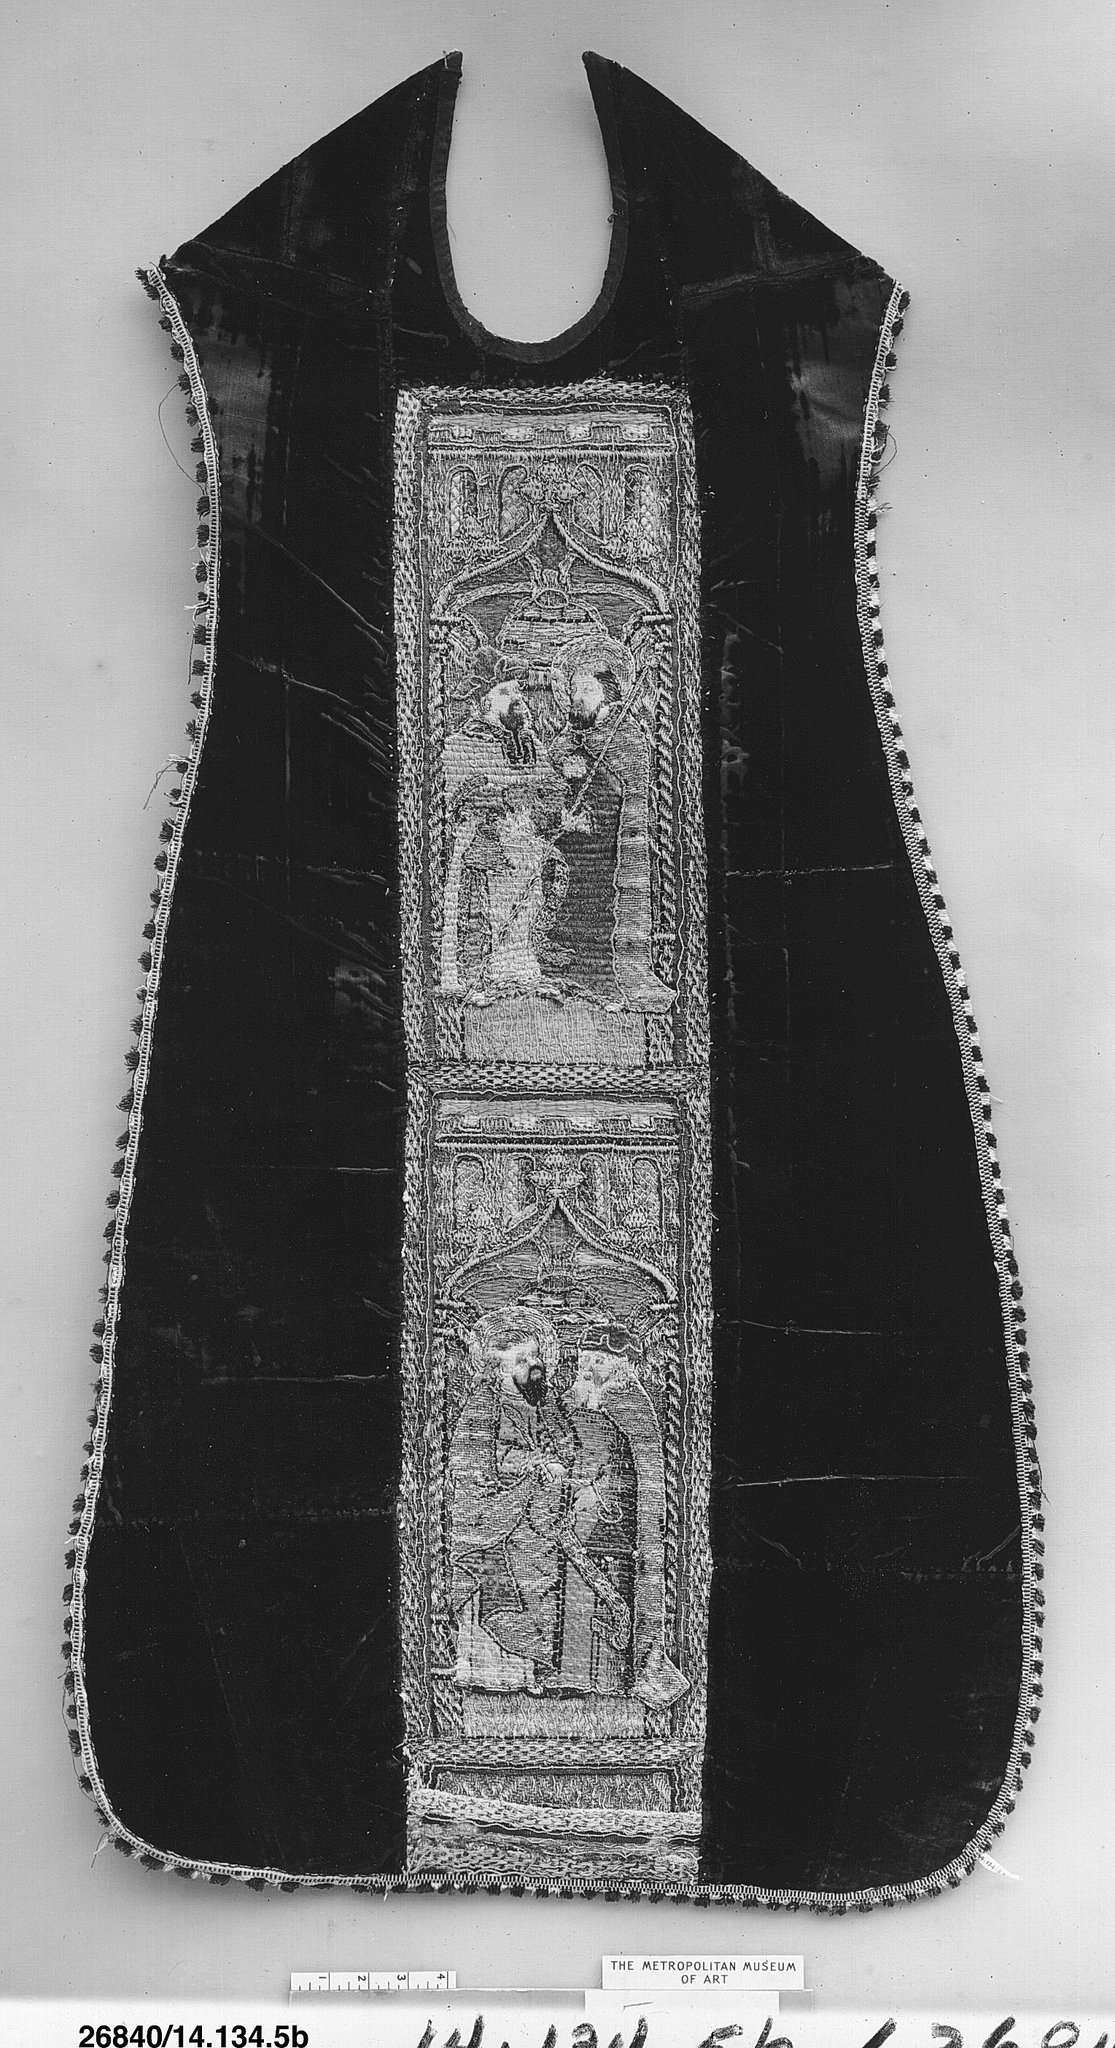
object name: chasuble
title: Chasuble with Virgin and Child, Apostles and Prophets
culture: french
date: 1401-1500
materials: gold thread, silk, velvet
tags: men,apostles,madonna and child